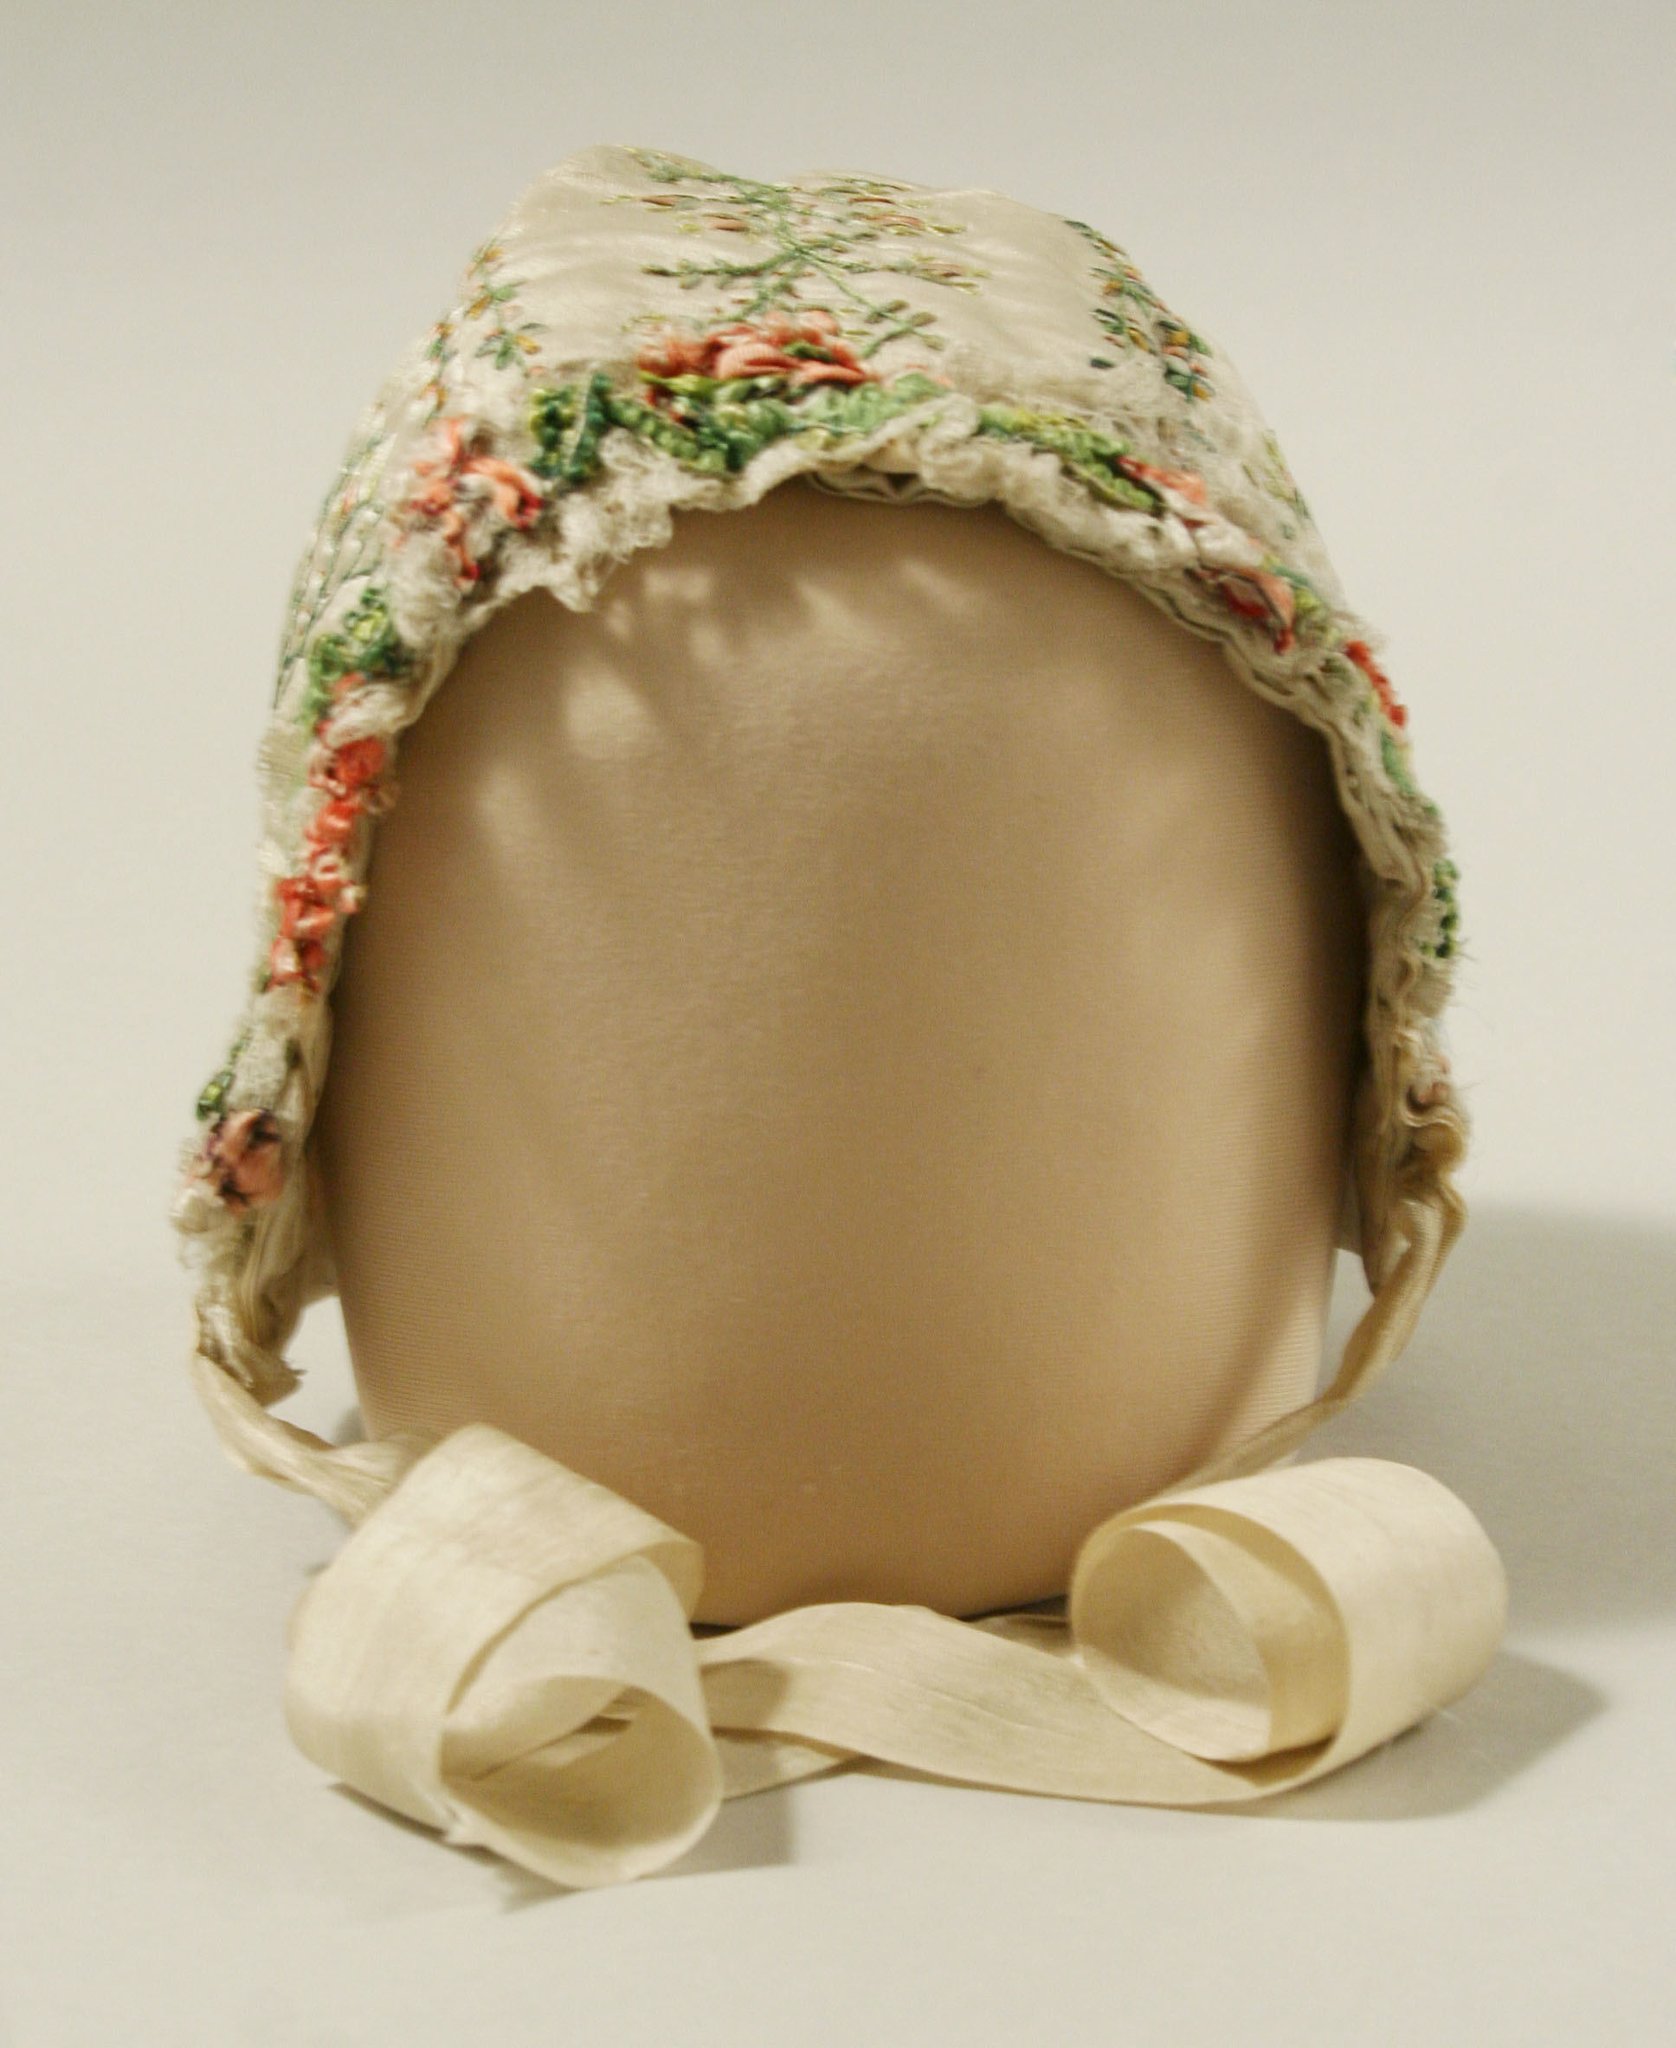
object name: cap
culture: french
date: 1701-1800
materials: silk